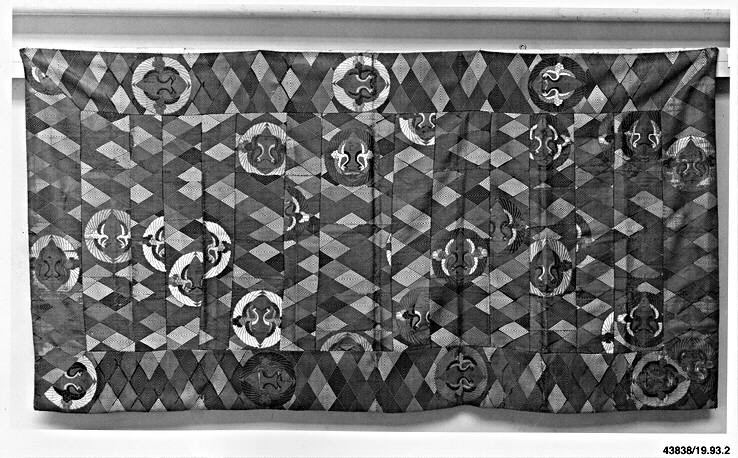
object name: robe, priest's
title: Priest's Robe (Shichijō)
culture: japanese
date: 1596-1615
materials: silk